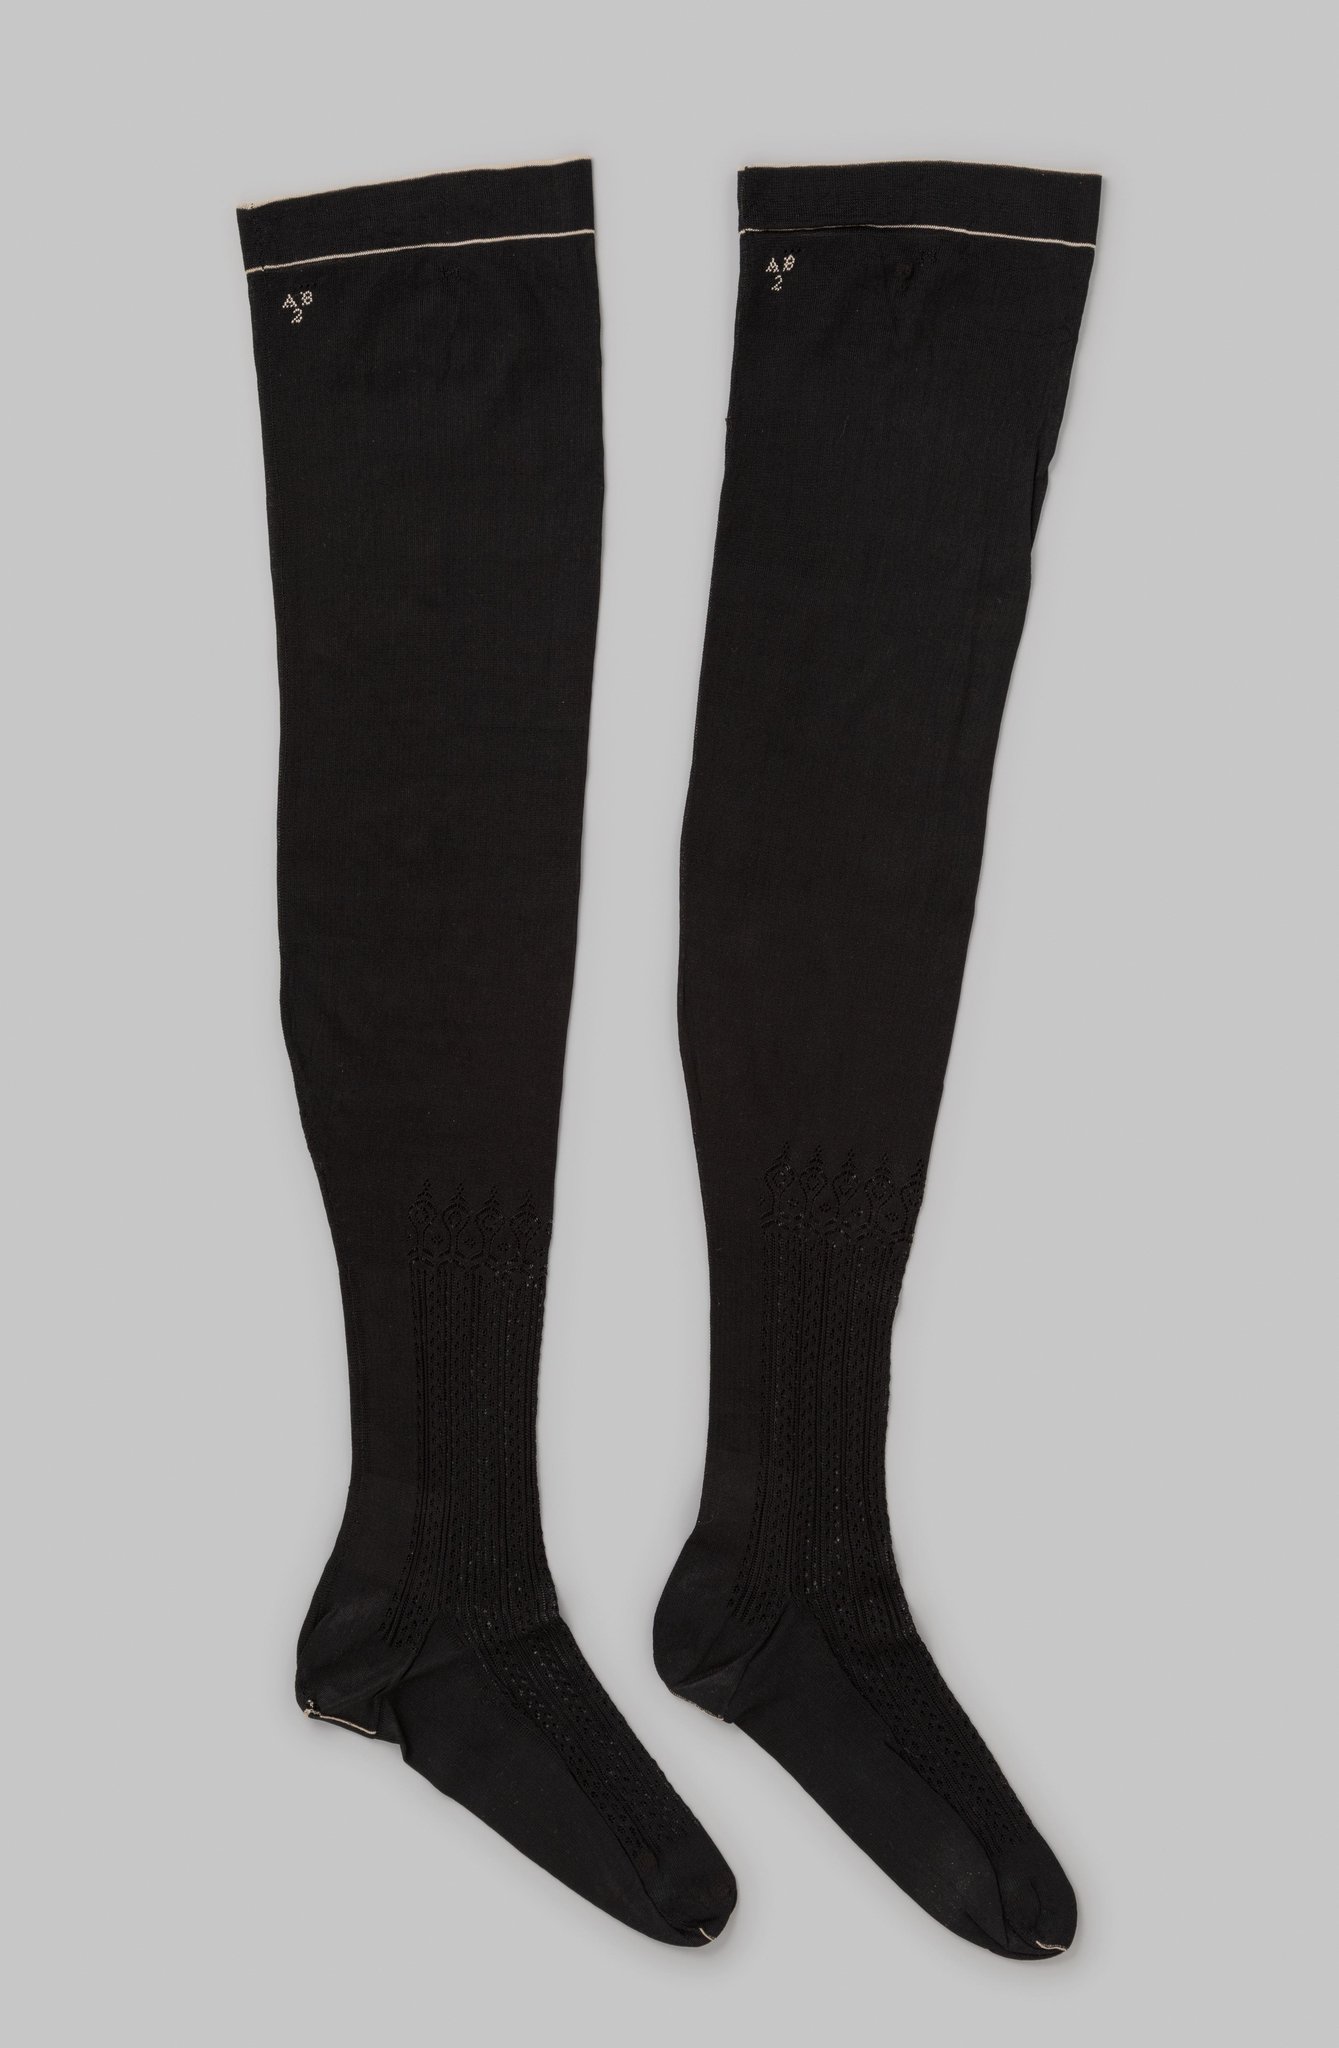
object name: stocking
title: Kous van zwarte zijde, opengewerkte klinken en wreef, dubbele boord afgezet met wit randje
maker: Anonymous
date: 1900-1925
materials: silk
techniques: cross stitching, embroidery, embroidered, knitting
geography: canada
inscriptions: initials: ‘AB 2’, initials: ‘M’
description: Paar kousen van zwarte zijde. Opengewerkte klinken en wreef met geometrische ajour versiering. Dubbele boord afgezet met wit randje. Naad middenachter. Met witte zijde gemerkt in kruissteek: AB 2.